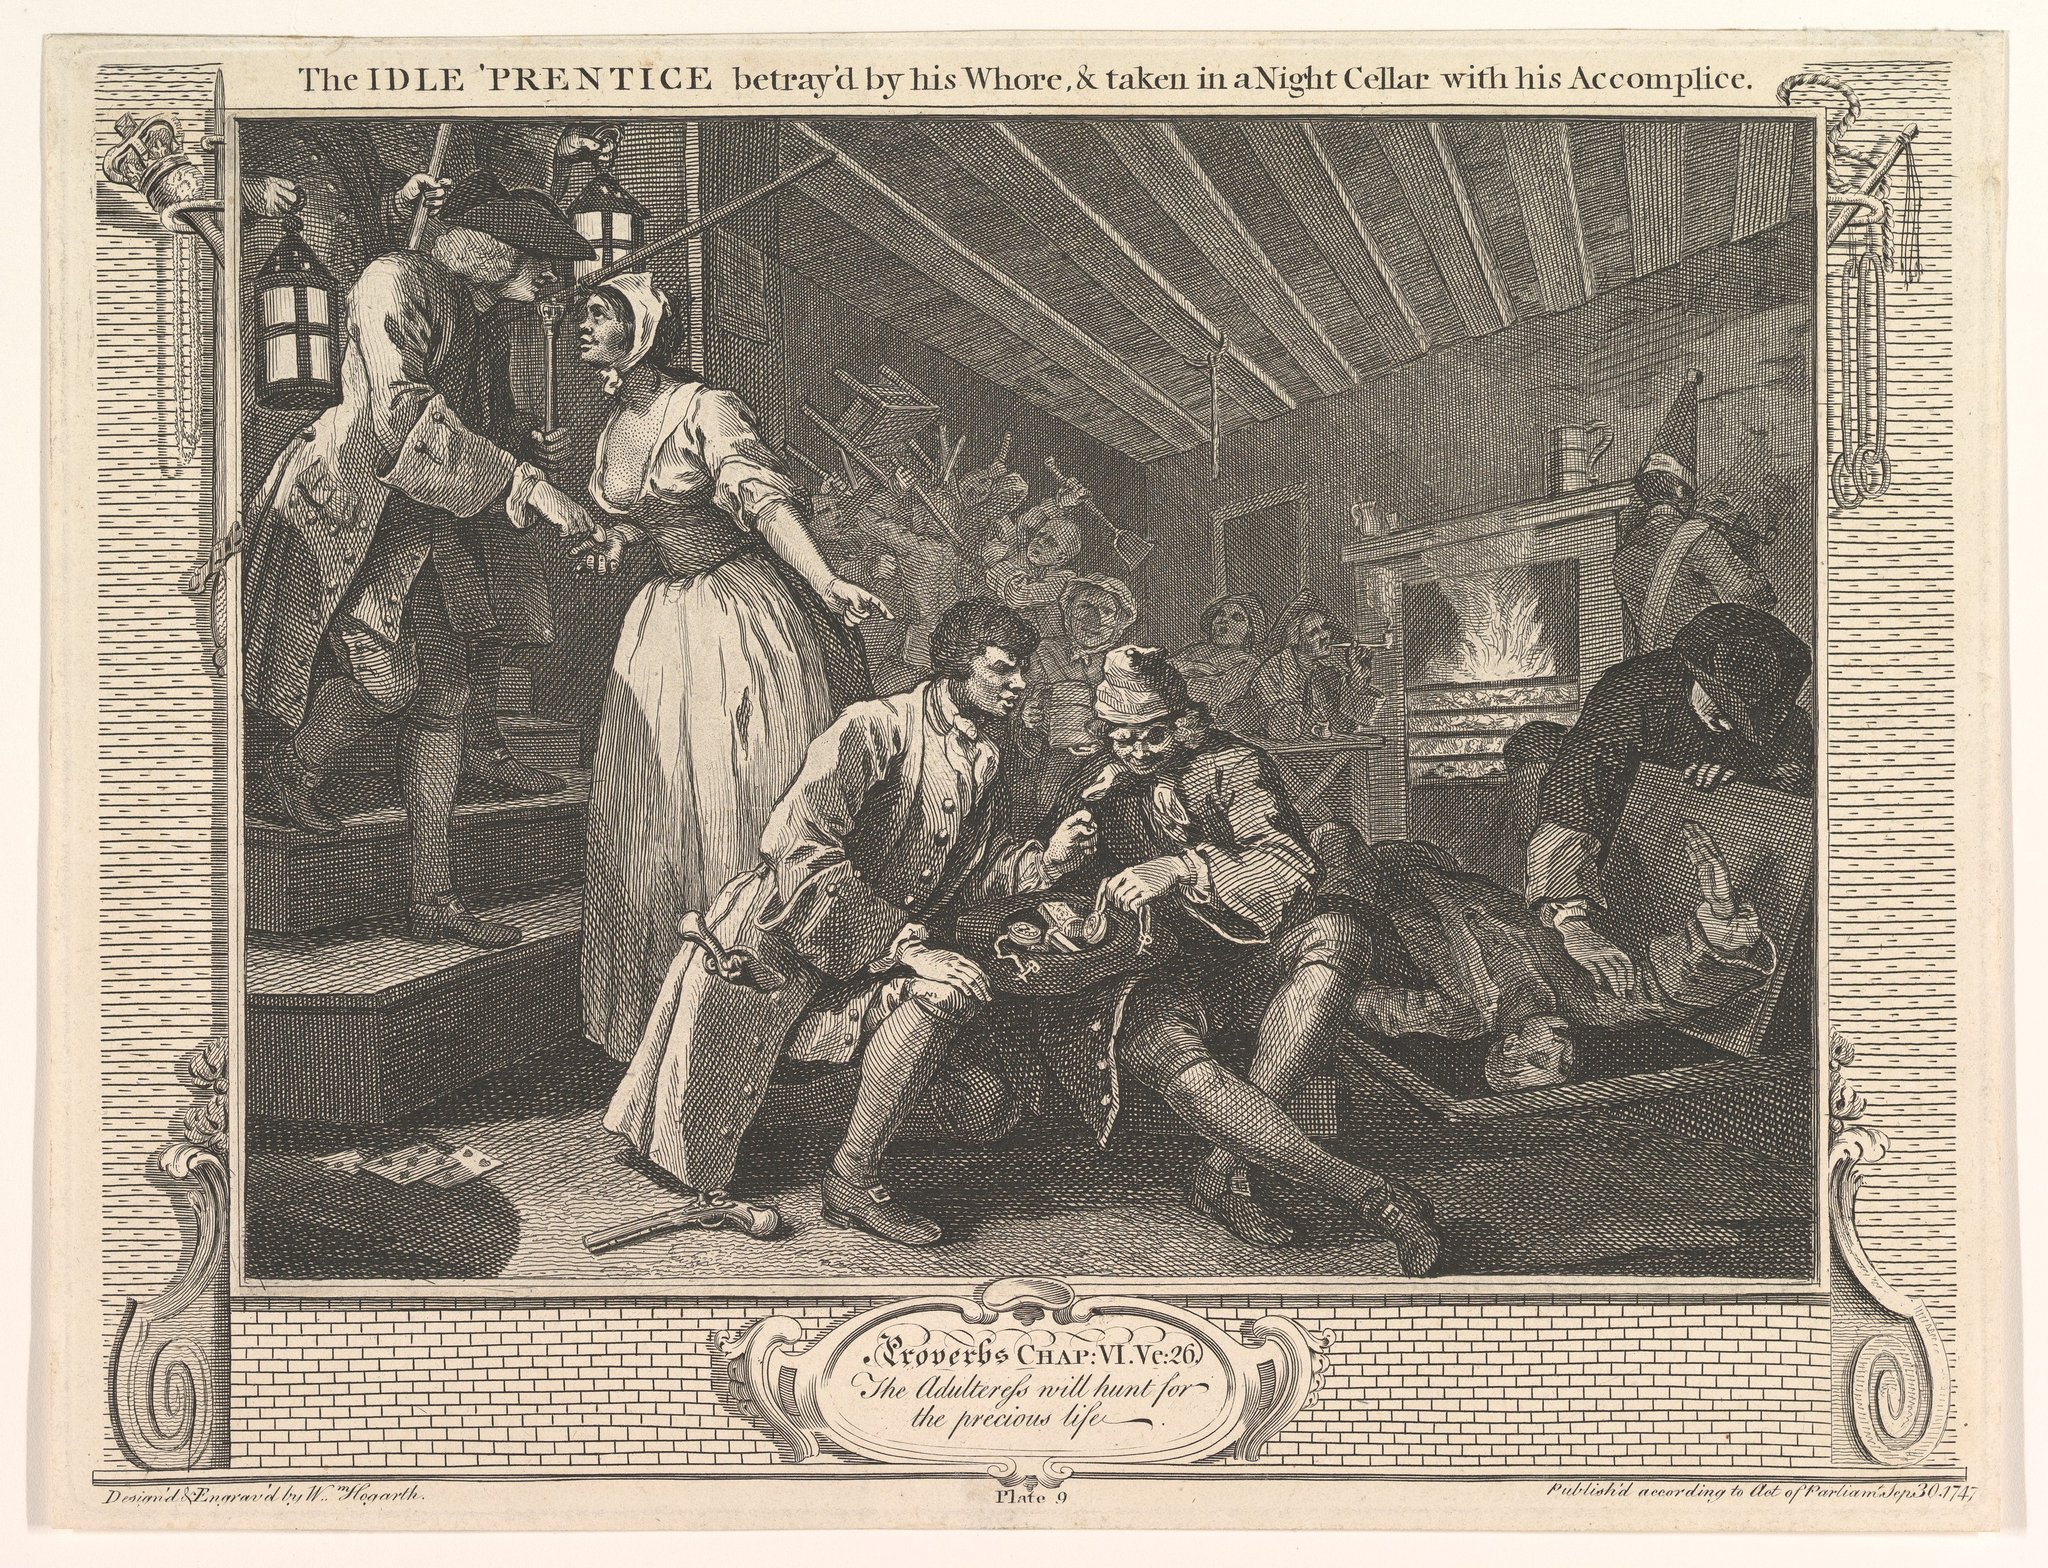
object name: print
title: The Idle 'Prentice Betrayed by his Whore and Taken in a Night Cellar with his Accomplice (Industry and Idleness, plate 9)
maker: william hogarth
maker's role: artist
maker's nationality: british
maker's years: 1697-1764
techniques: engraving, etching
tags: men,women